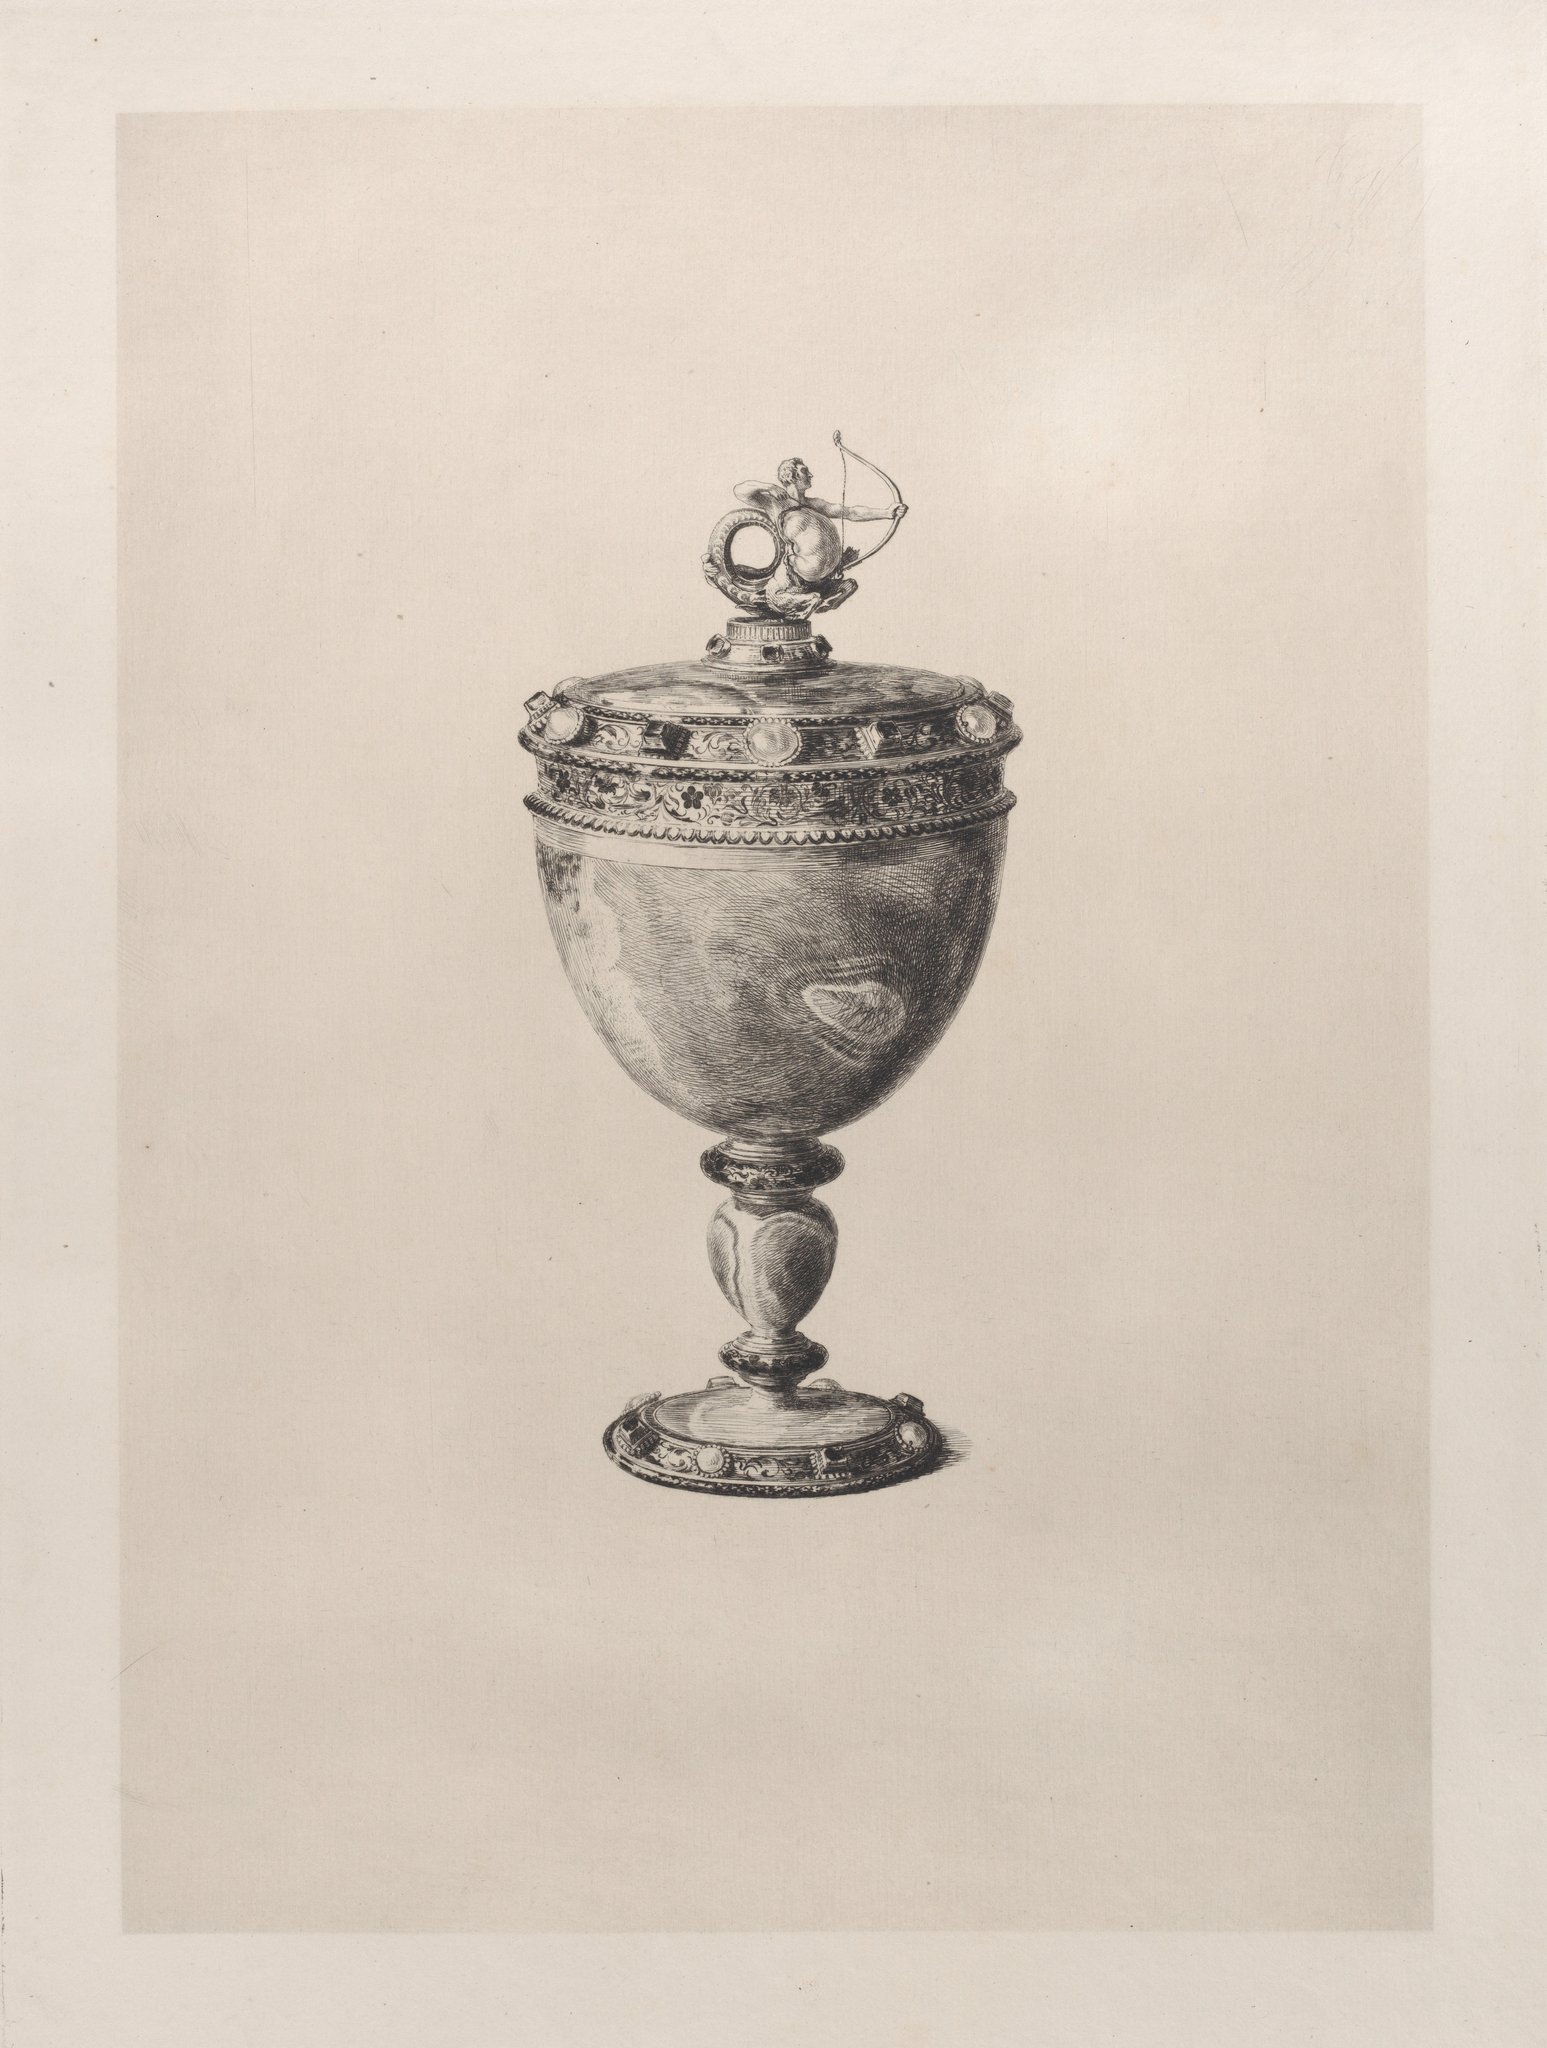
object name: print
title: Oriental Cup made from Agate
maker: jules-ferdinand jacquemart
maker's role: artist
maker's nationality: french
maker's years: 1837-1880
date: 1868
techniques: etching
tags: cups